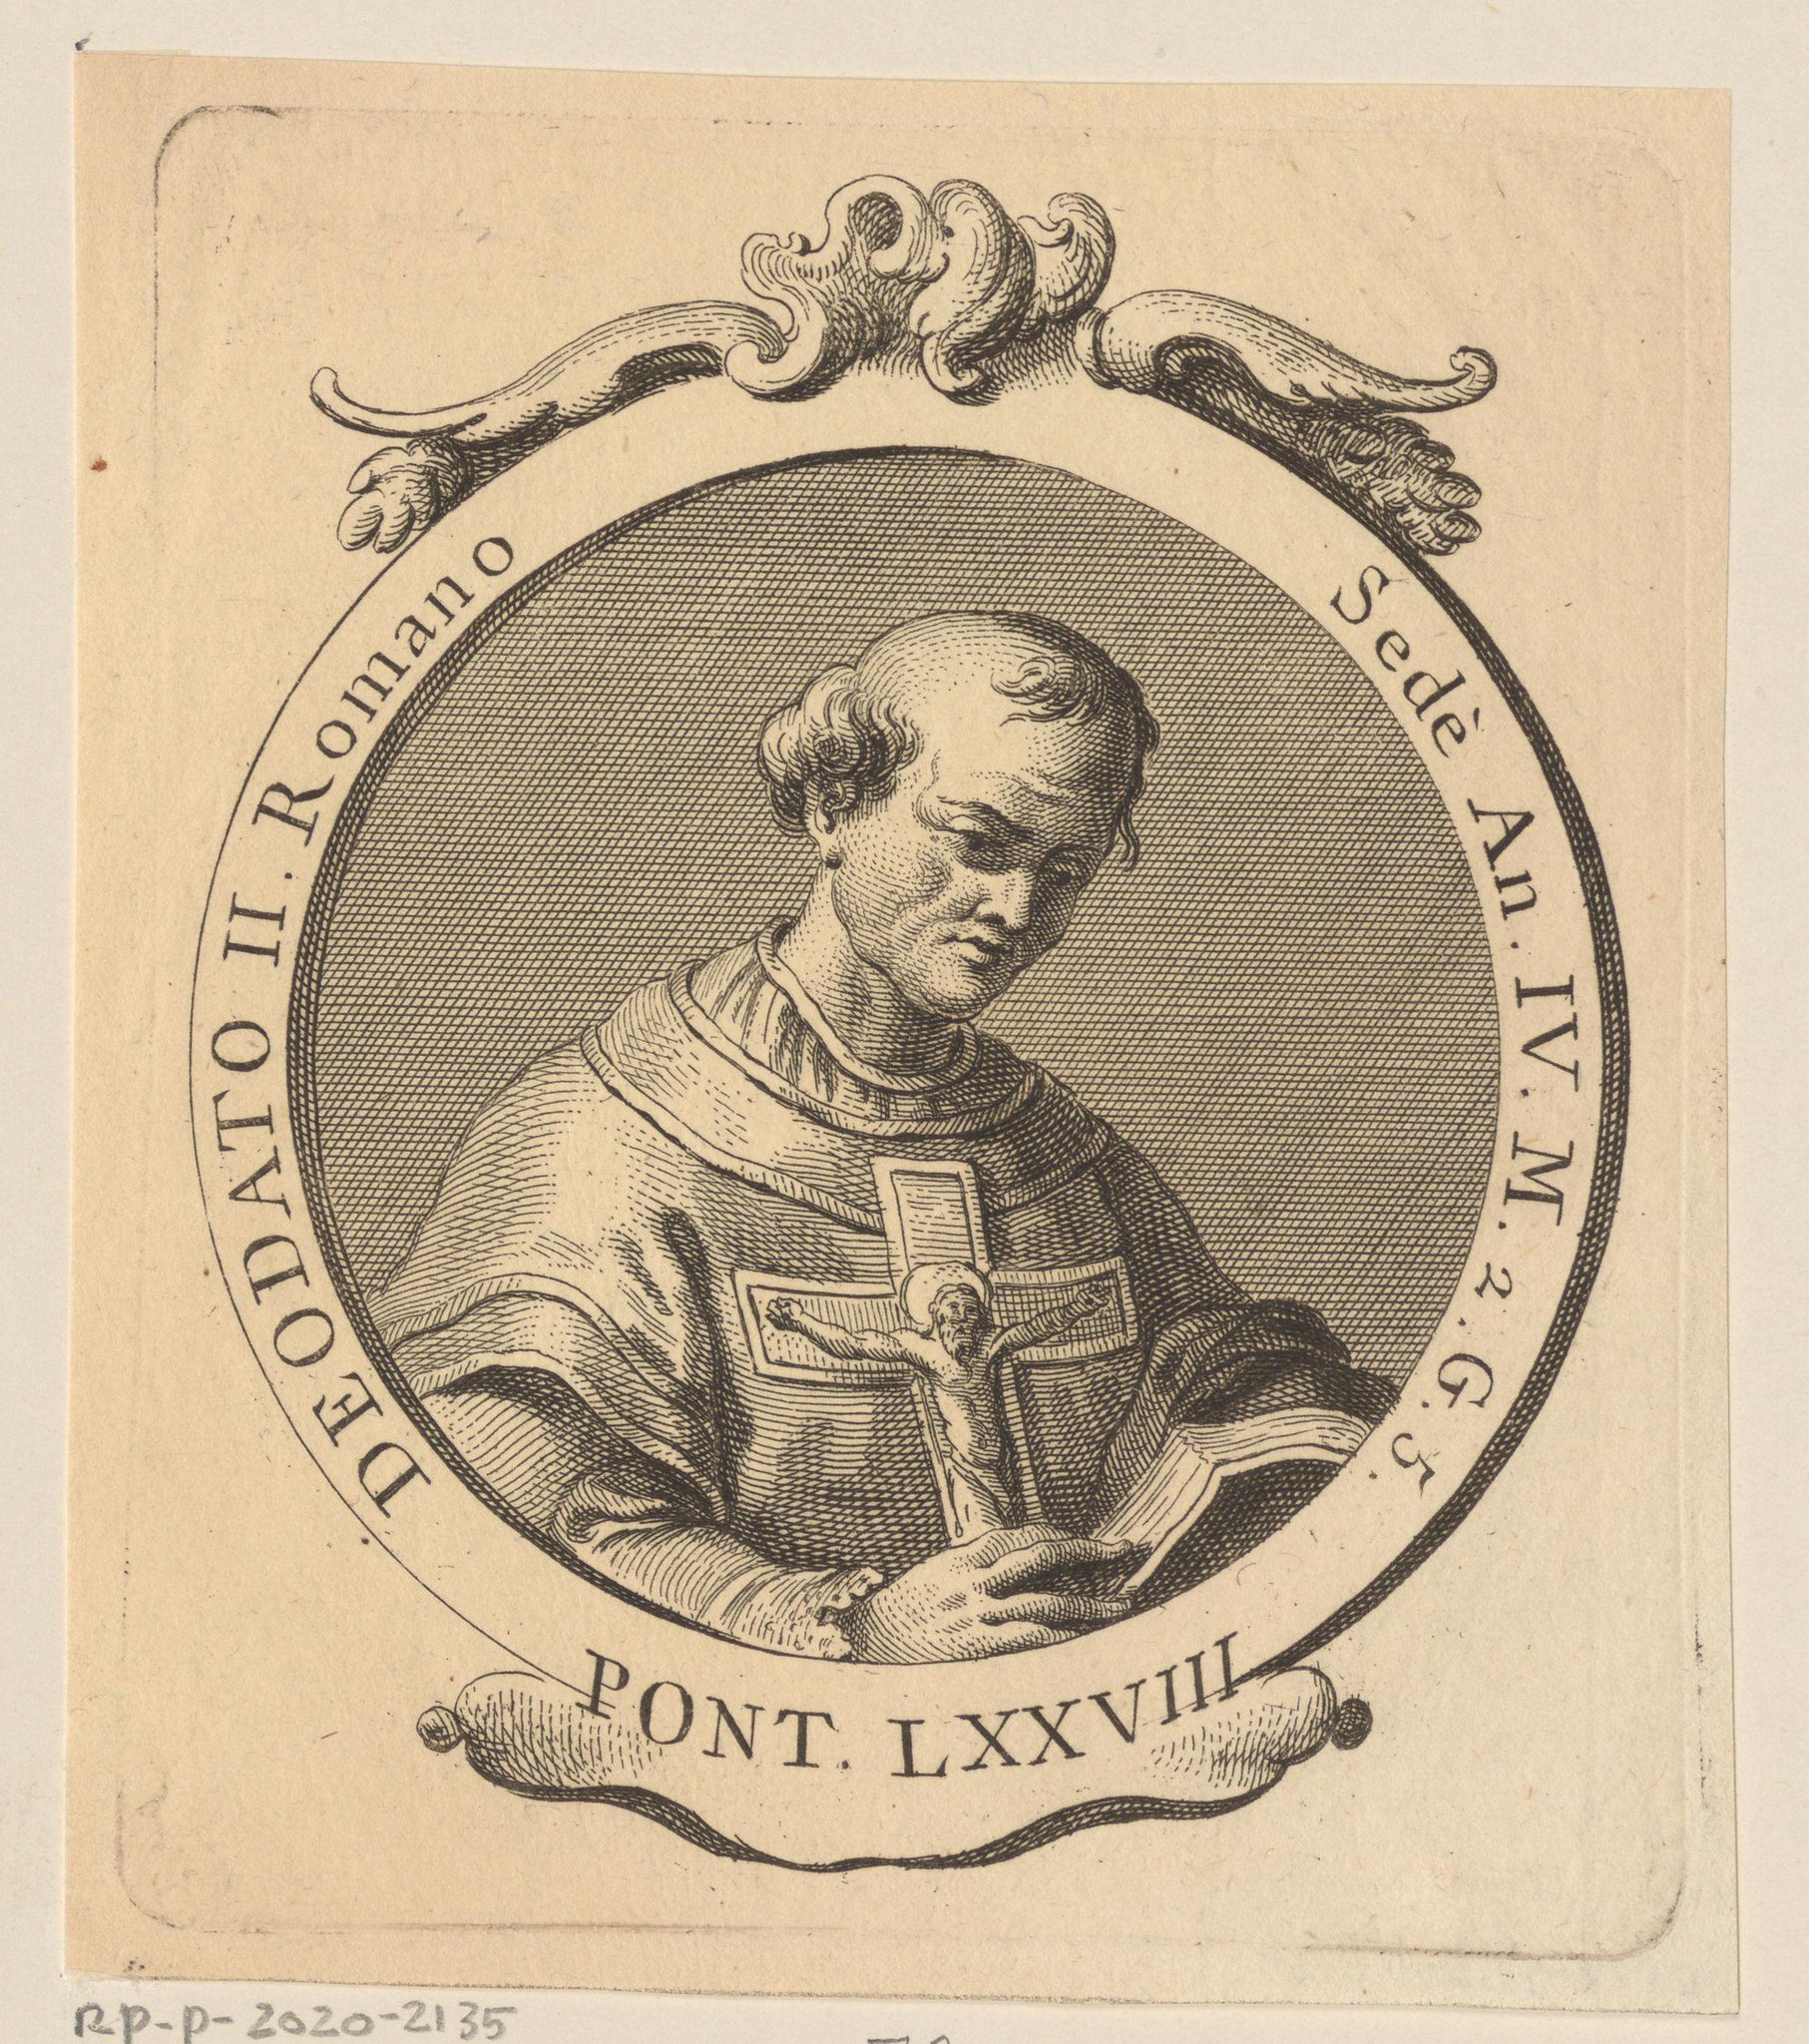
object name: print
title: Portret van paus Adeodatus II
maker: Anonymous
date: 1575-1674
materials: paper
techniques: etching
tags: historical persons, pope